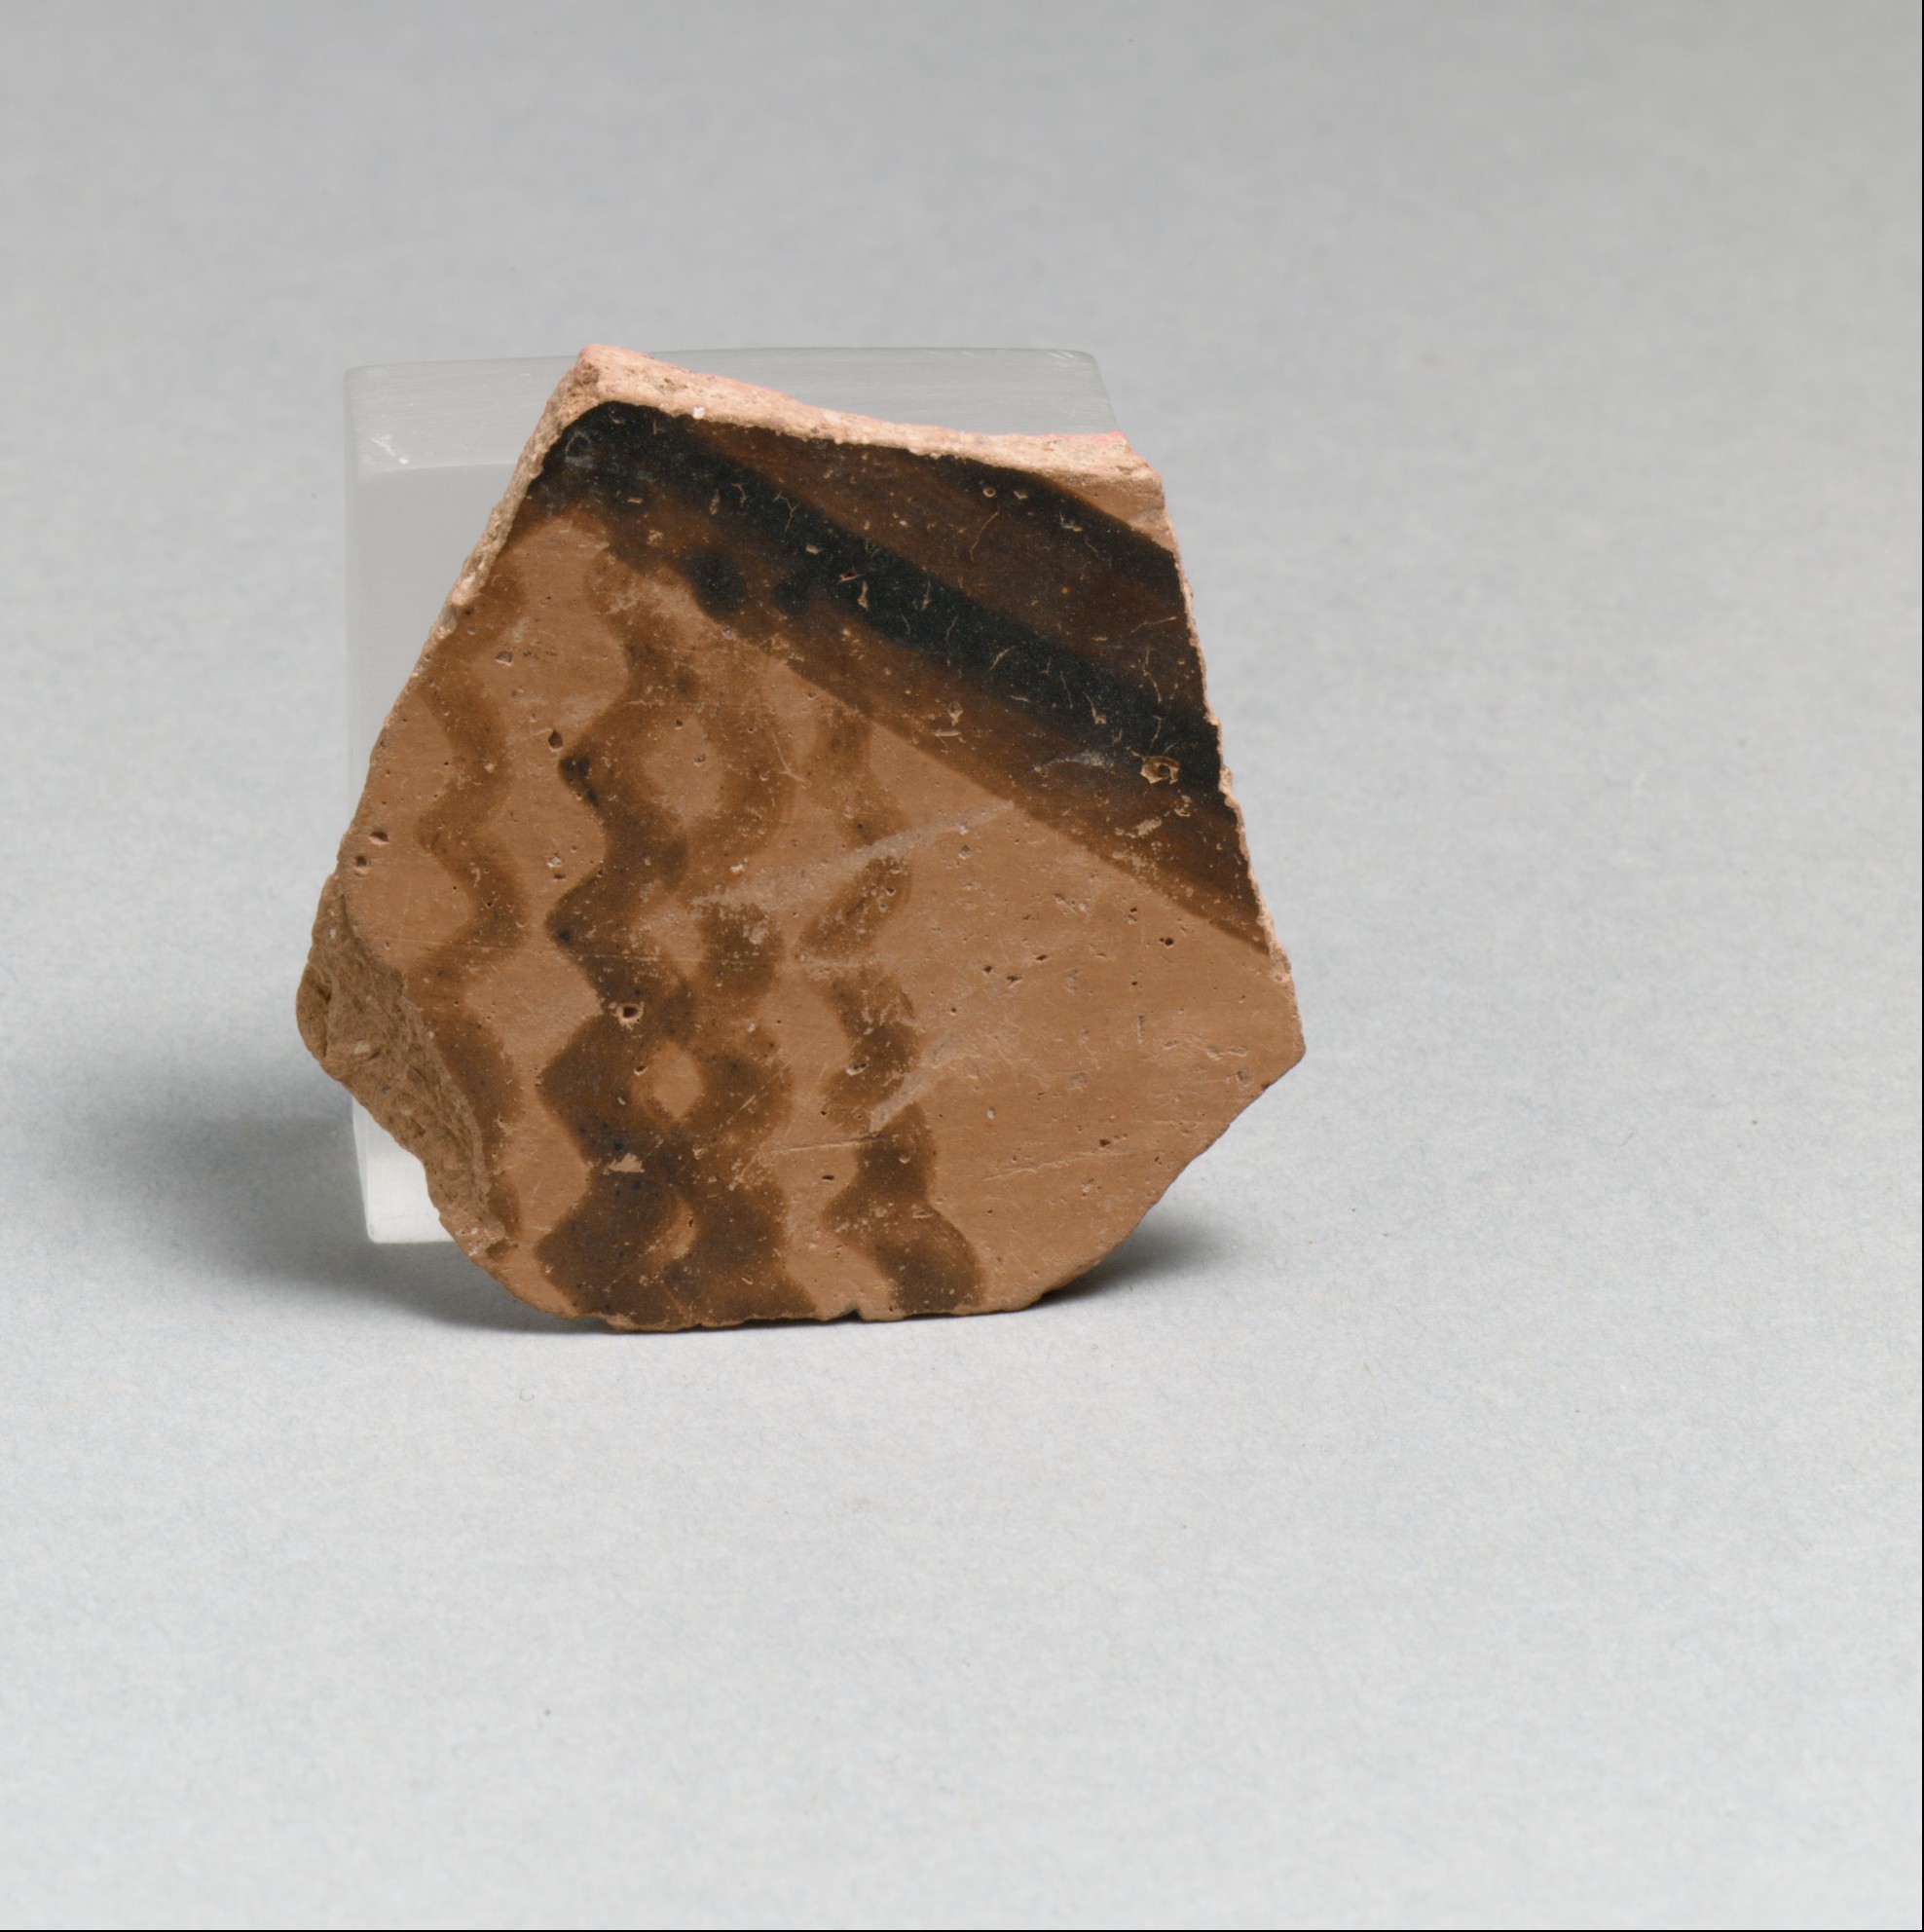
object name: vase fragment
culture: neolithic, hagiorgetika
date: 4000-3000 BCE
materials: terracotta